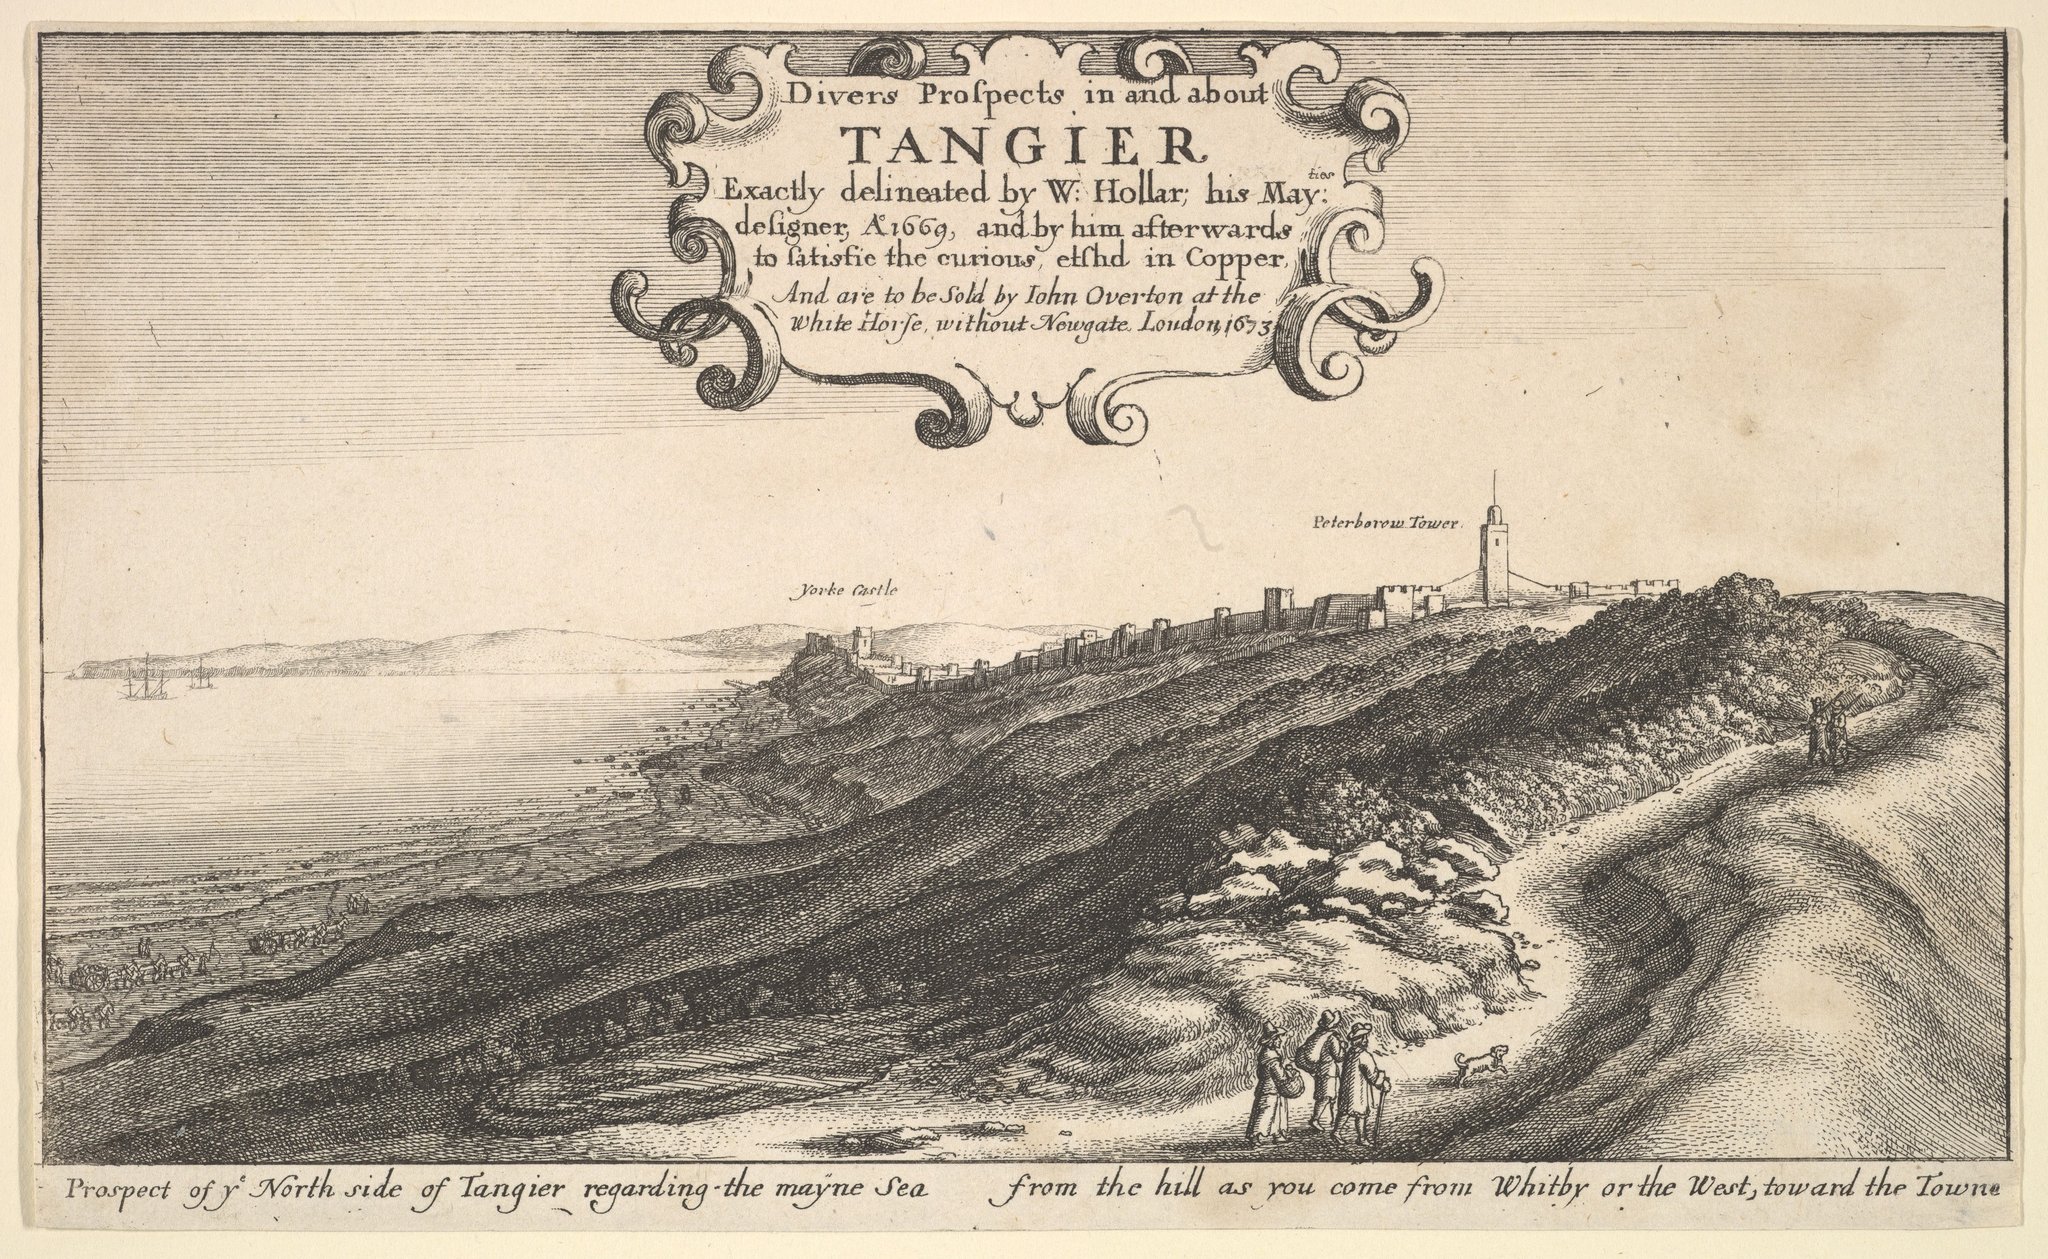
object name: print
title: Prospect of ye North side of Tangier regarding the mayne Sea from the hill as you come from Whitby or the West, toward the Towne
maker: wenceslaus hollar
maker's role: artist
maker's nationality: bohemian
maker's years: 1607-1677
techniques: etching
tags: seas,landscapes